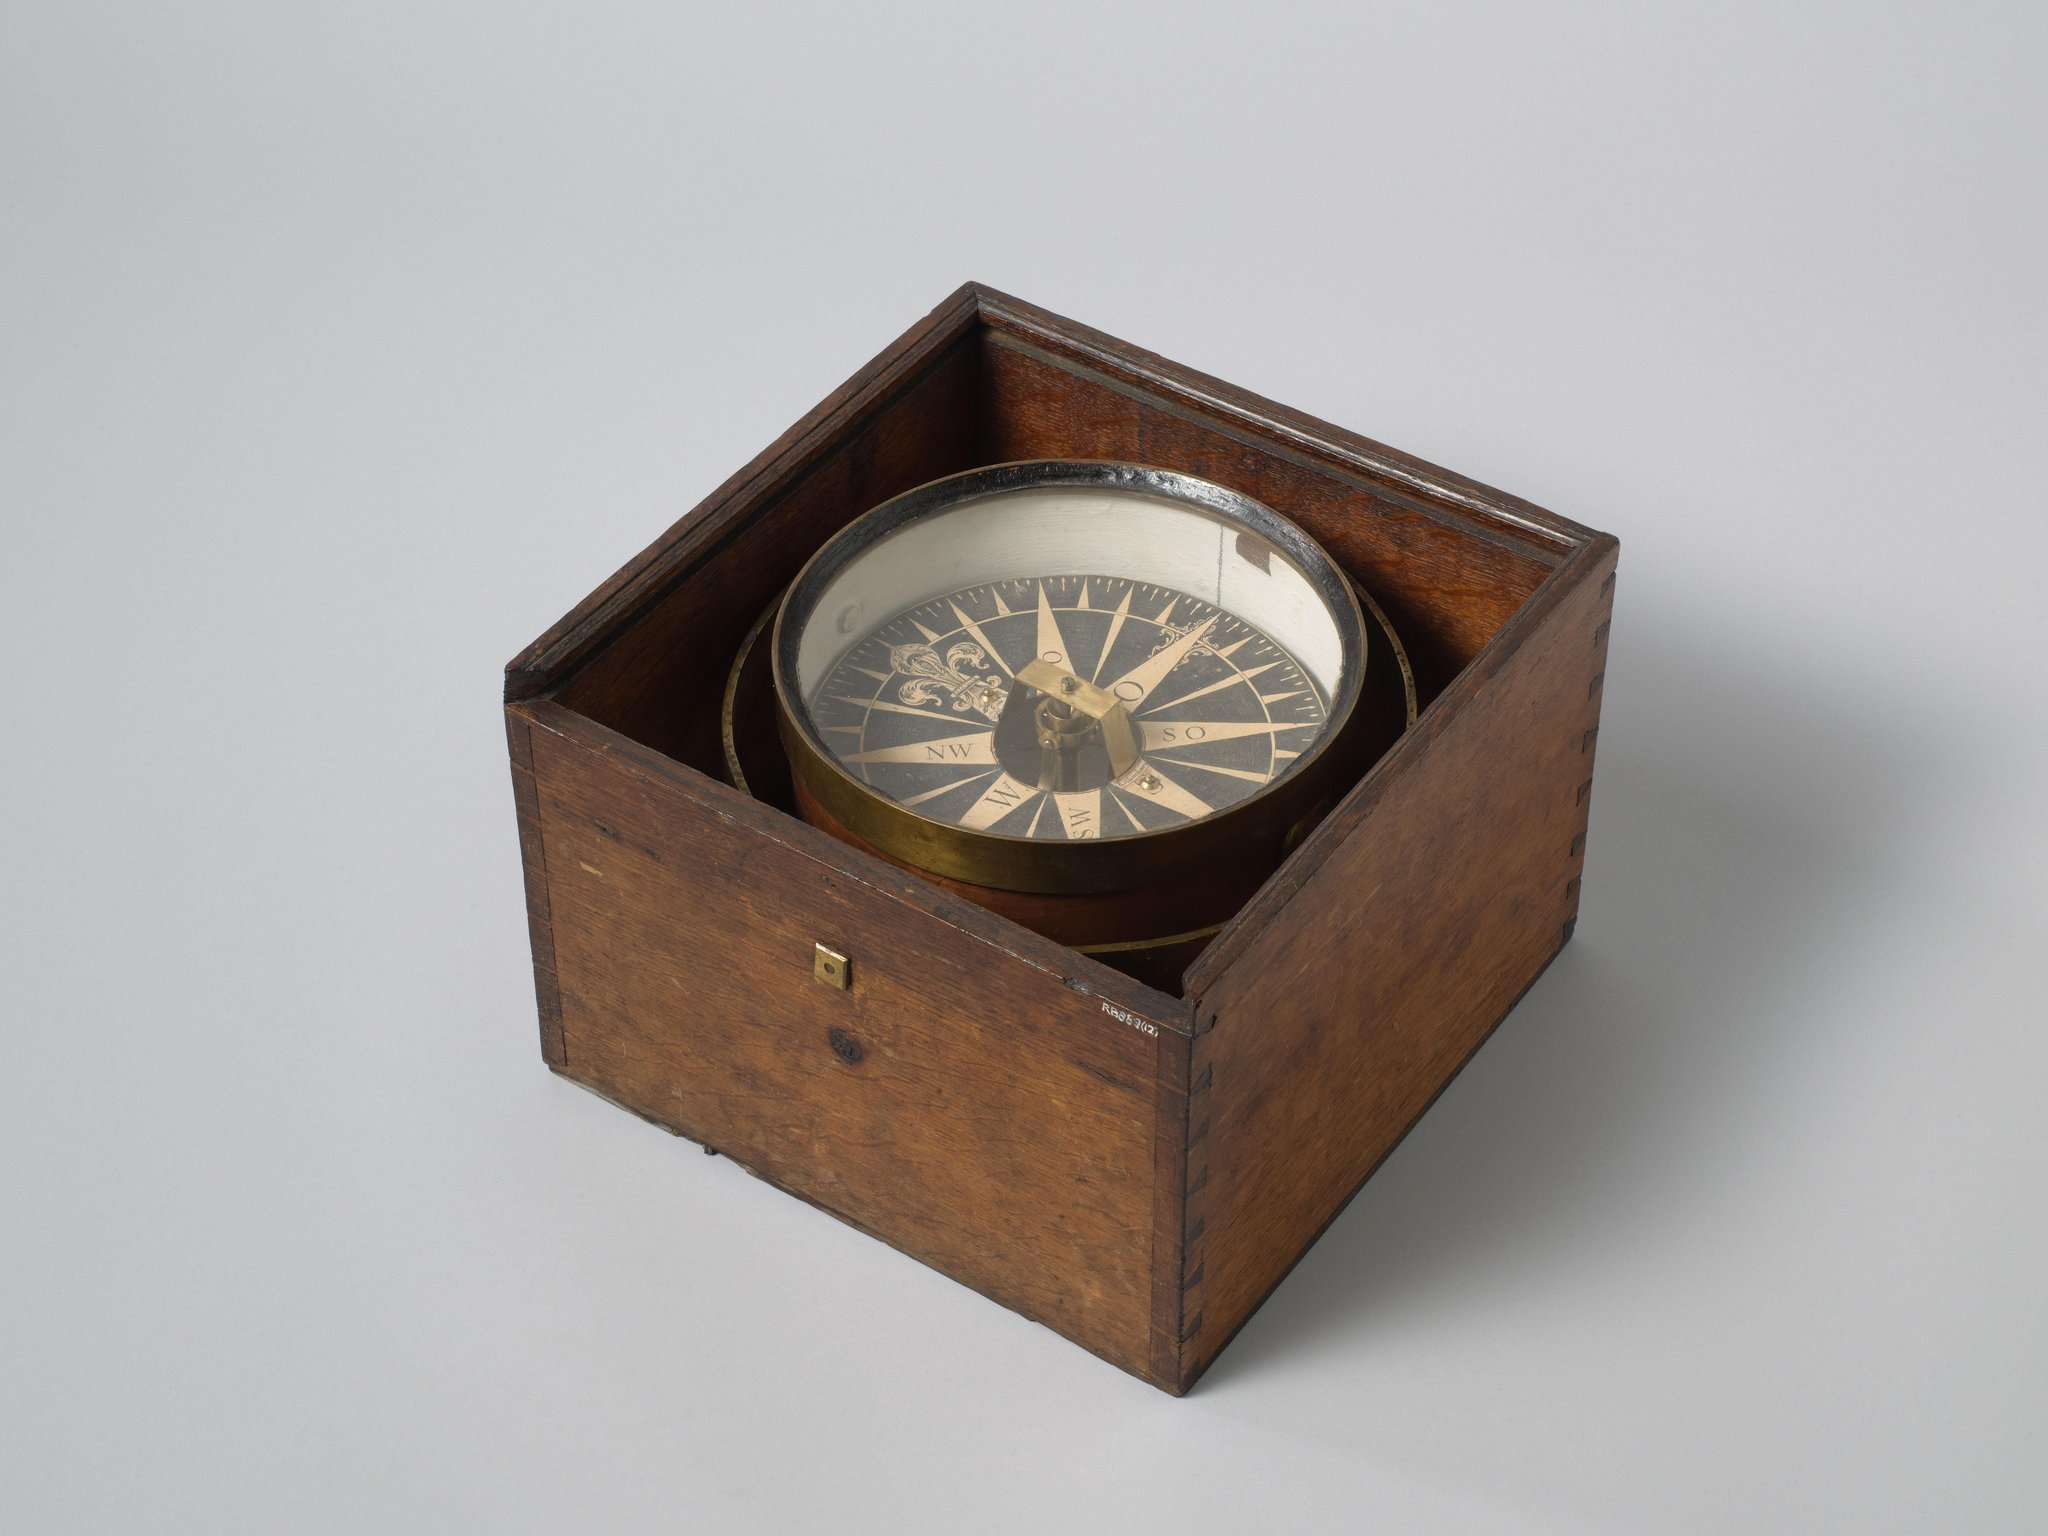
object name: compass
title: Azimuth compass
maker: j.p. weilbach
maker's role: kompasmaker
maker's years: 1770-1836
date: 1820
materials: brass, copper, glass, iron, lacquer, lead, paper, gemstone, wood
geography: copenhagen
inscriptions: inscription, on the compass card: ‘I·P·Weilbach // iKiöbenhavn’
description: Azimutkompas in cardanusring in een houten doos. De kompasketel is verzwaard met een loden gewicht onderin. De roos is op een eigenaardige manier opgehangen: in de ketel is een kleine cardanusring aangebracht, waarin een verticale as met gewicht onderaan hangt als een slinger. Het bovenvlak van deze as is uitgehold en van een edelsteen voorzien. De roos heeft een gat in het midden, waarover een messing brug loopt met een pen recht naar beneden, die op de edelsteen van de as staat. Door het gat in de roos is een enkele kompasnaald niet meer mogelijk: dit is opgevangen door twee parallelle naalden. Met rode lak onderop is de roos uitgebalanceerd. Doos en deksel dragen een stempel van een anker in een cirkel.